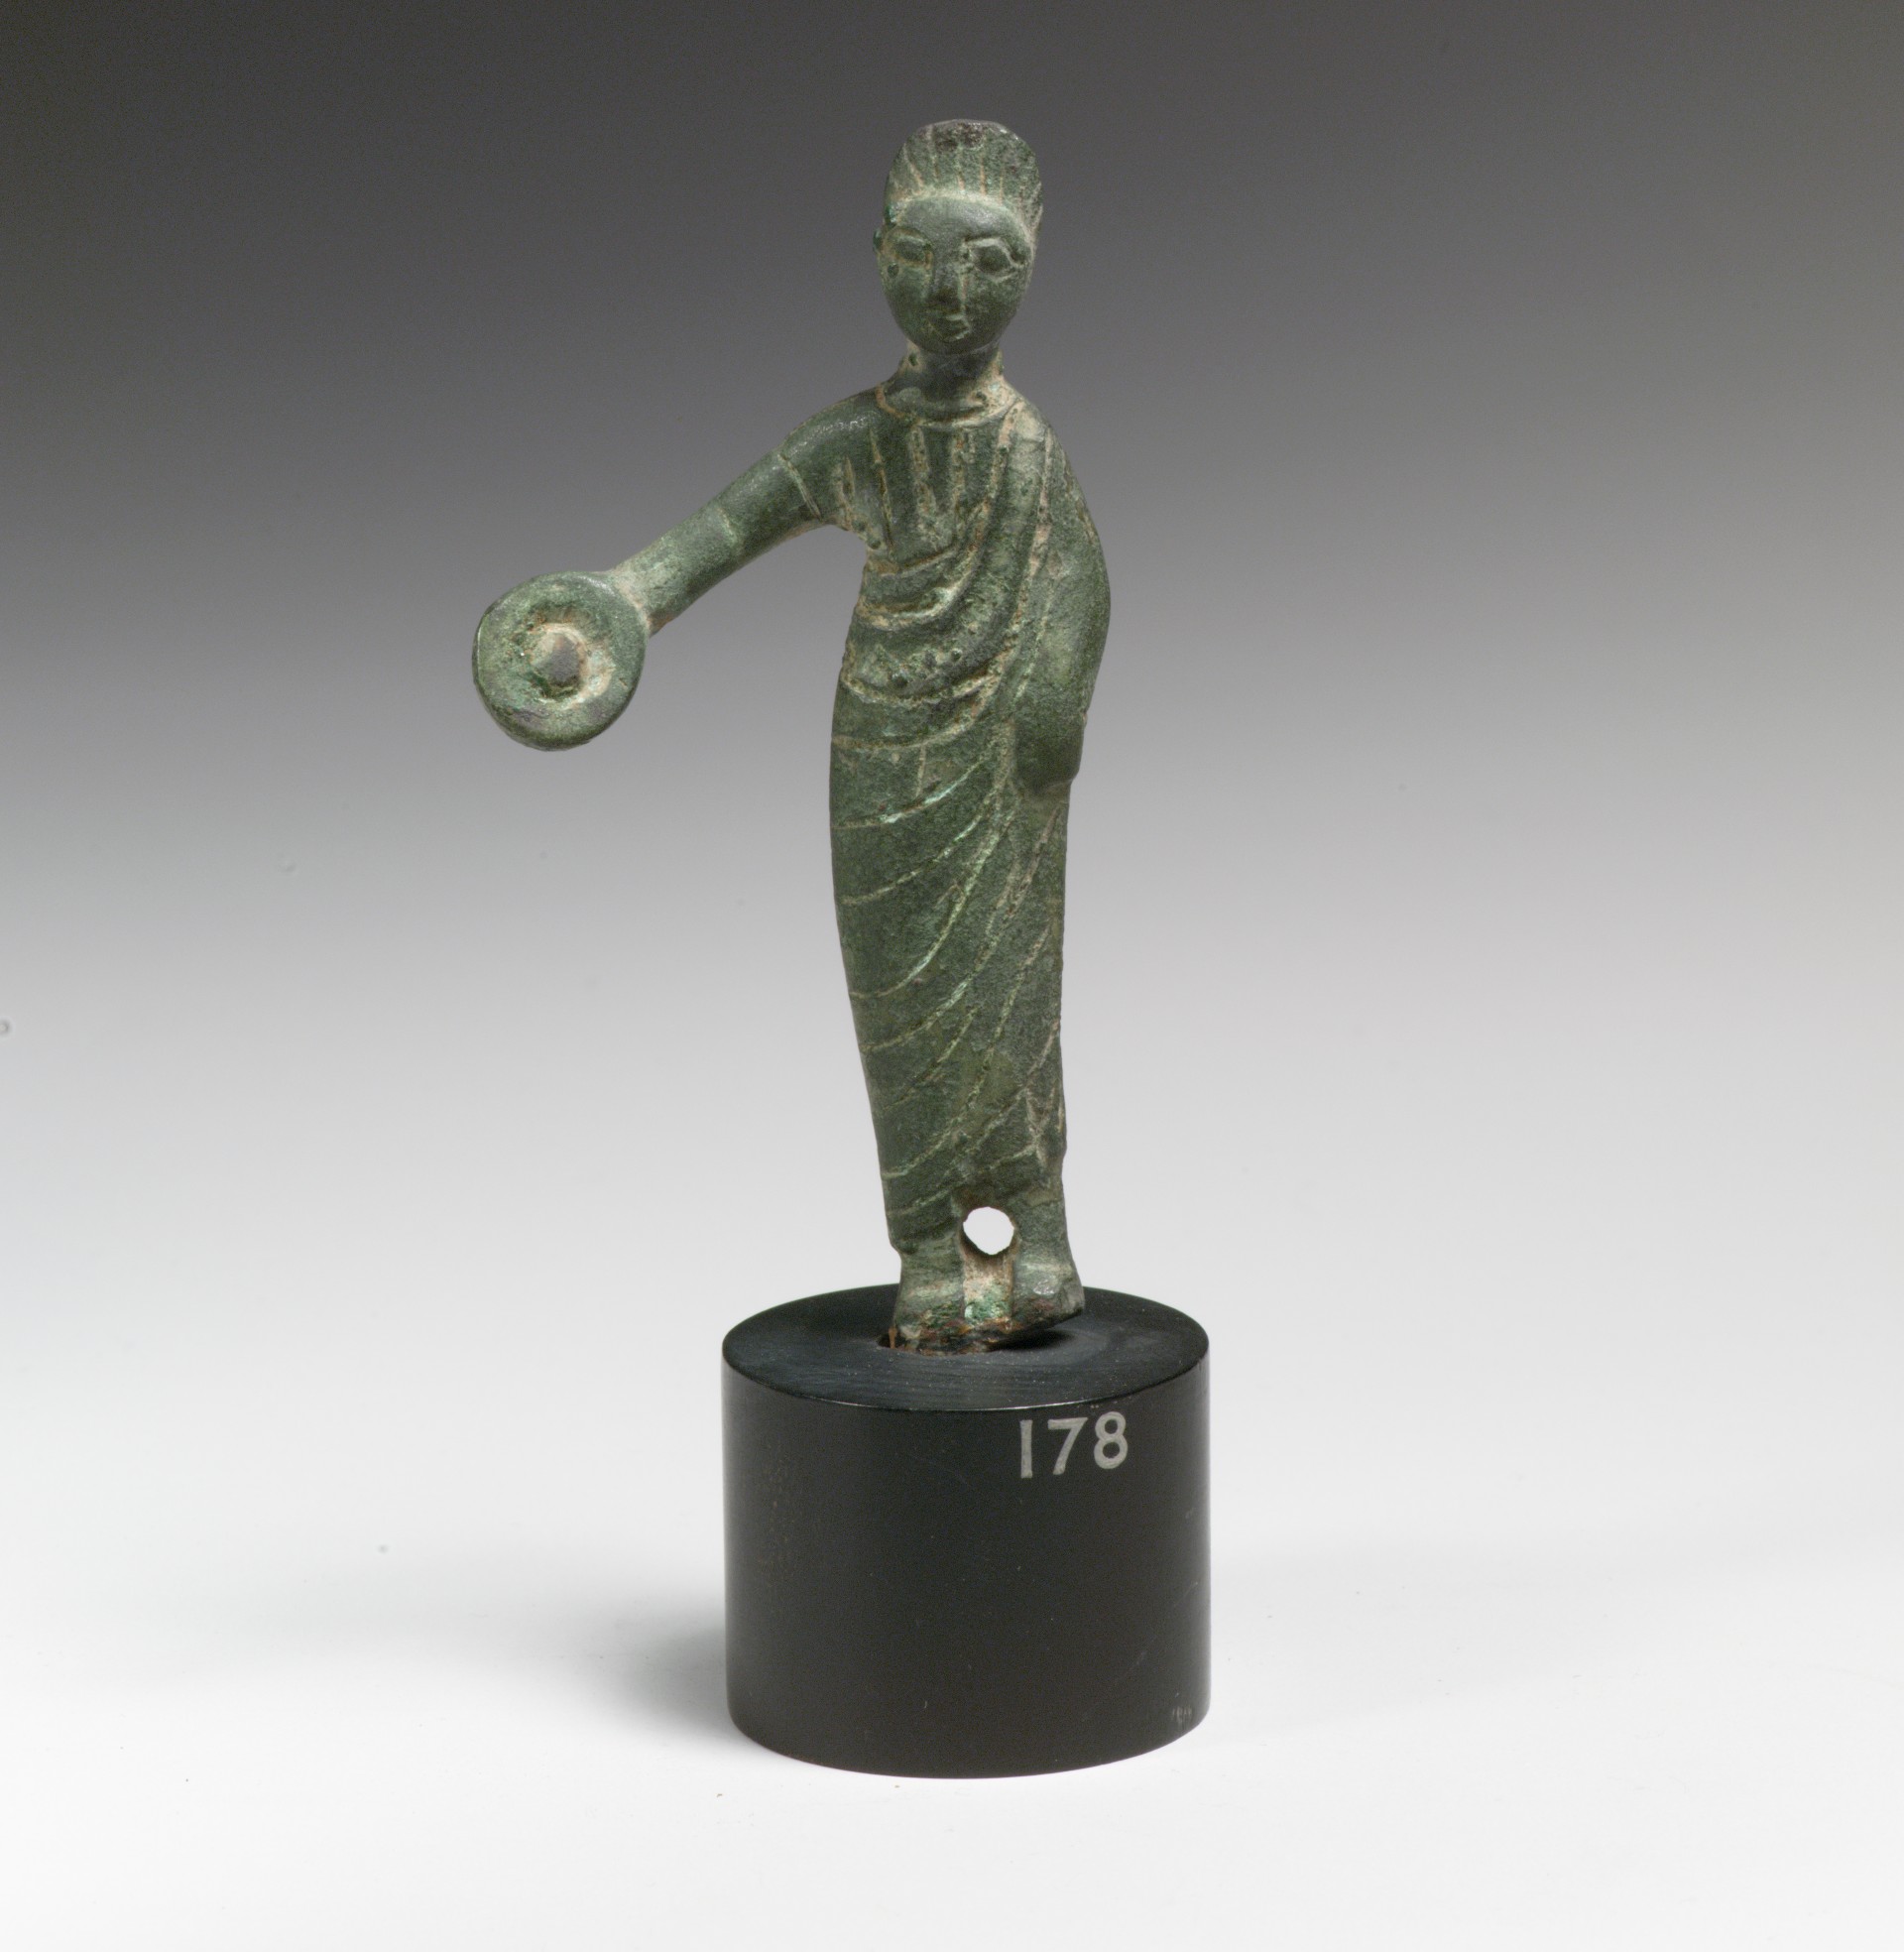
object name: statuette of a woman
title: Statuette of a woman holding a phiale (libation vessel)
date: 7000 BCE-330 CE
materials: bronze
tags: women